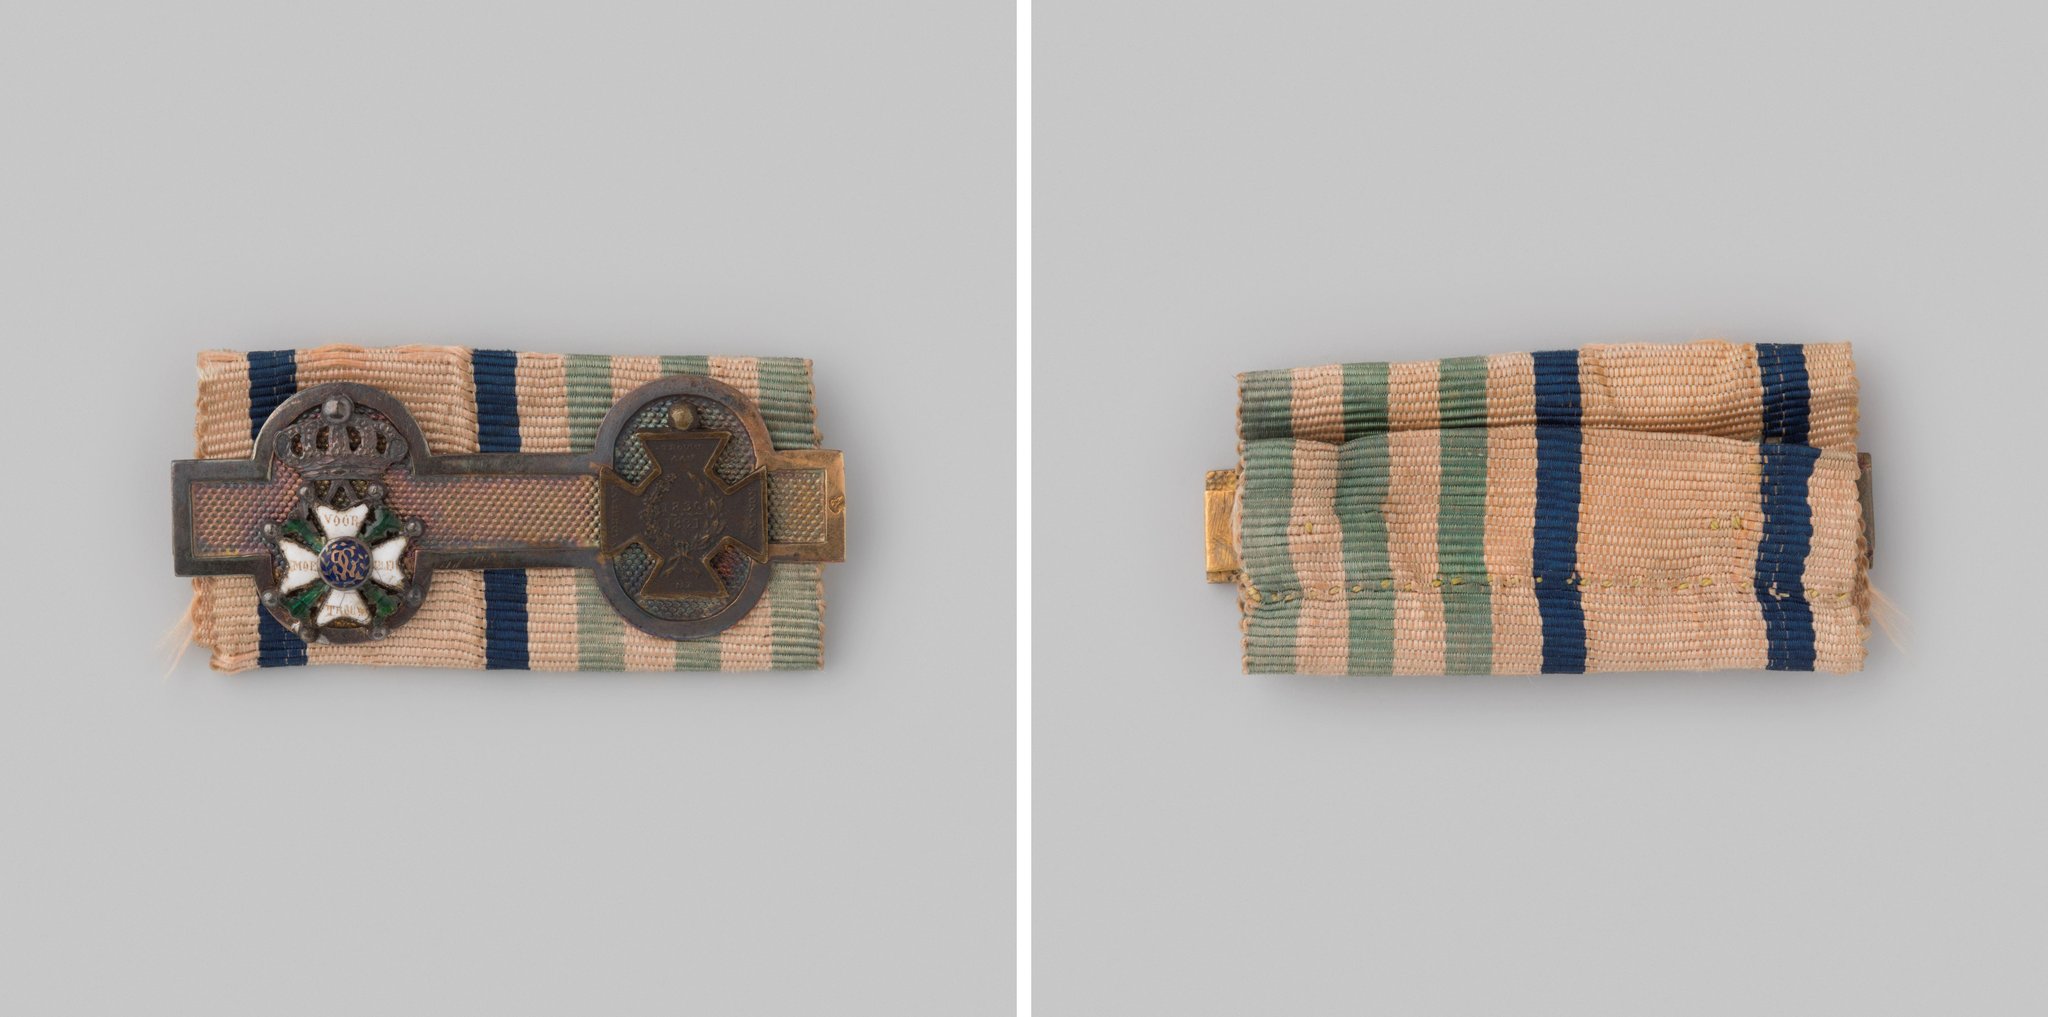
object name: honorary medal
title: Ridderkruis 4e klasse van de Militaire Willemsorde voor moed, beleid en trouw, op gouden gesp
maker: Anonymous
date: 1815-1831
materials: gold, silver, textile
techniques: gilding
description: Zilveren draagteken met verguldsel, email en lint, op gouden gesp.